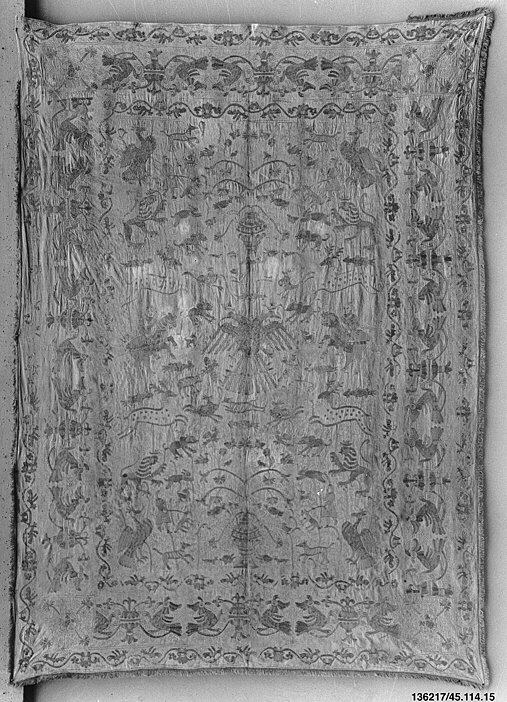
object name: hanging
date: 1601-1700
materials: linen, silk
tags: animals,birds,deer,lions